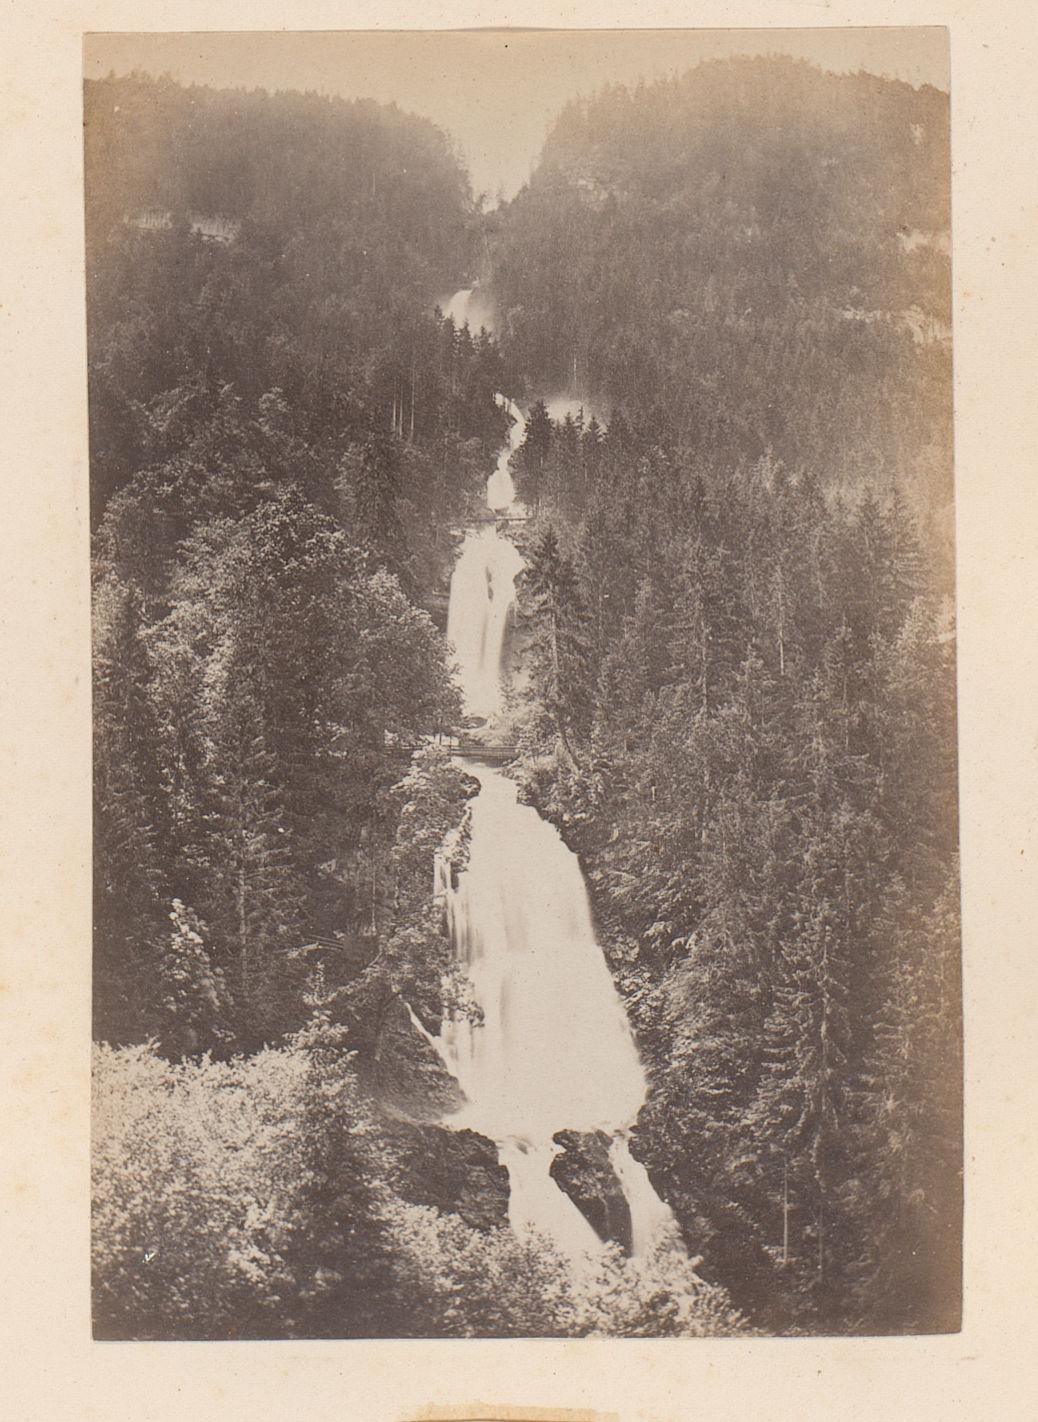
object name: photograph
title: Le Giessebach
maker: Anonymous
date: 1860-1890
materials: paper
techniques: albumen print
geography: bern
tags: waterfall, mountains